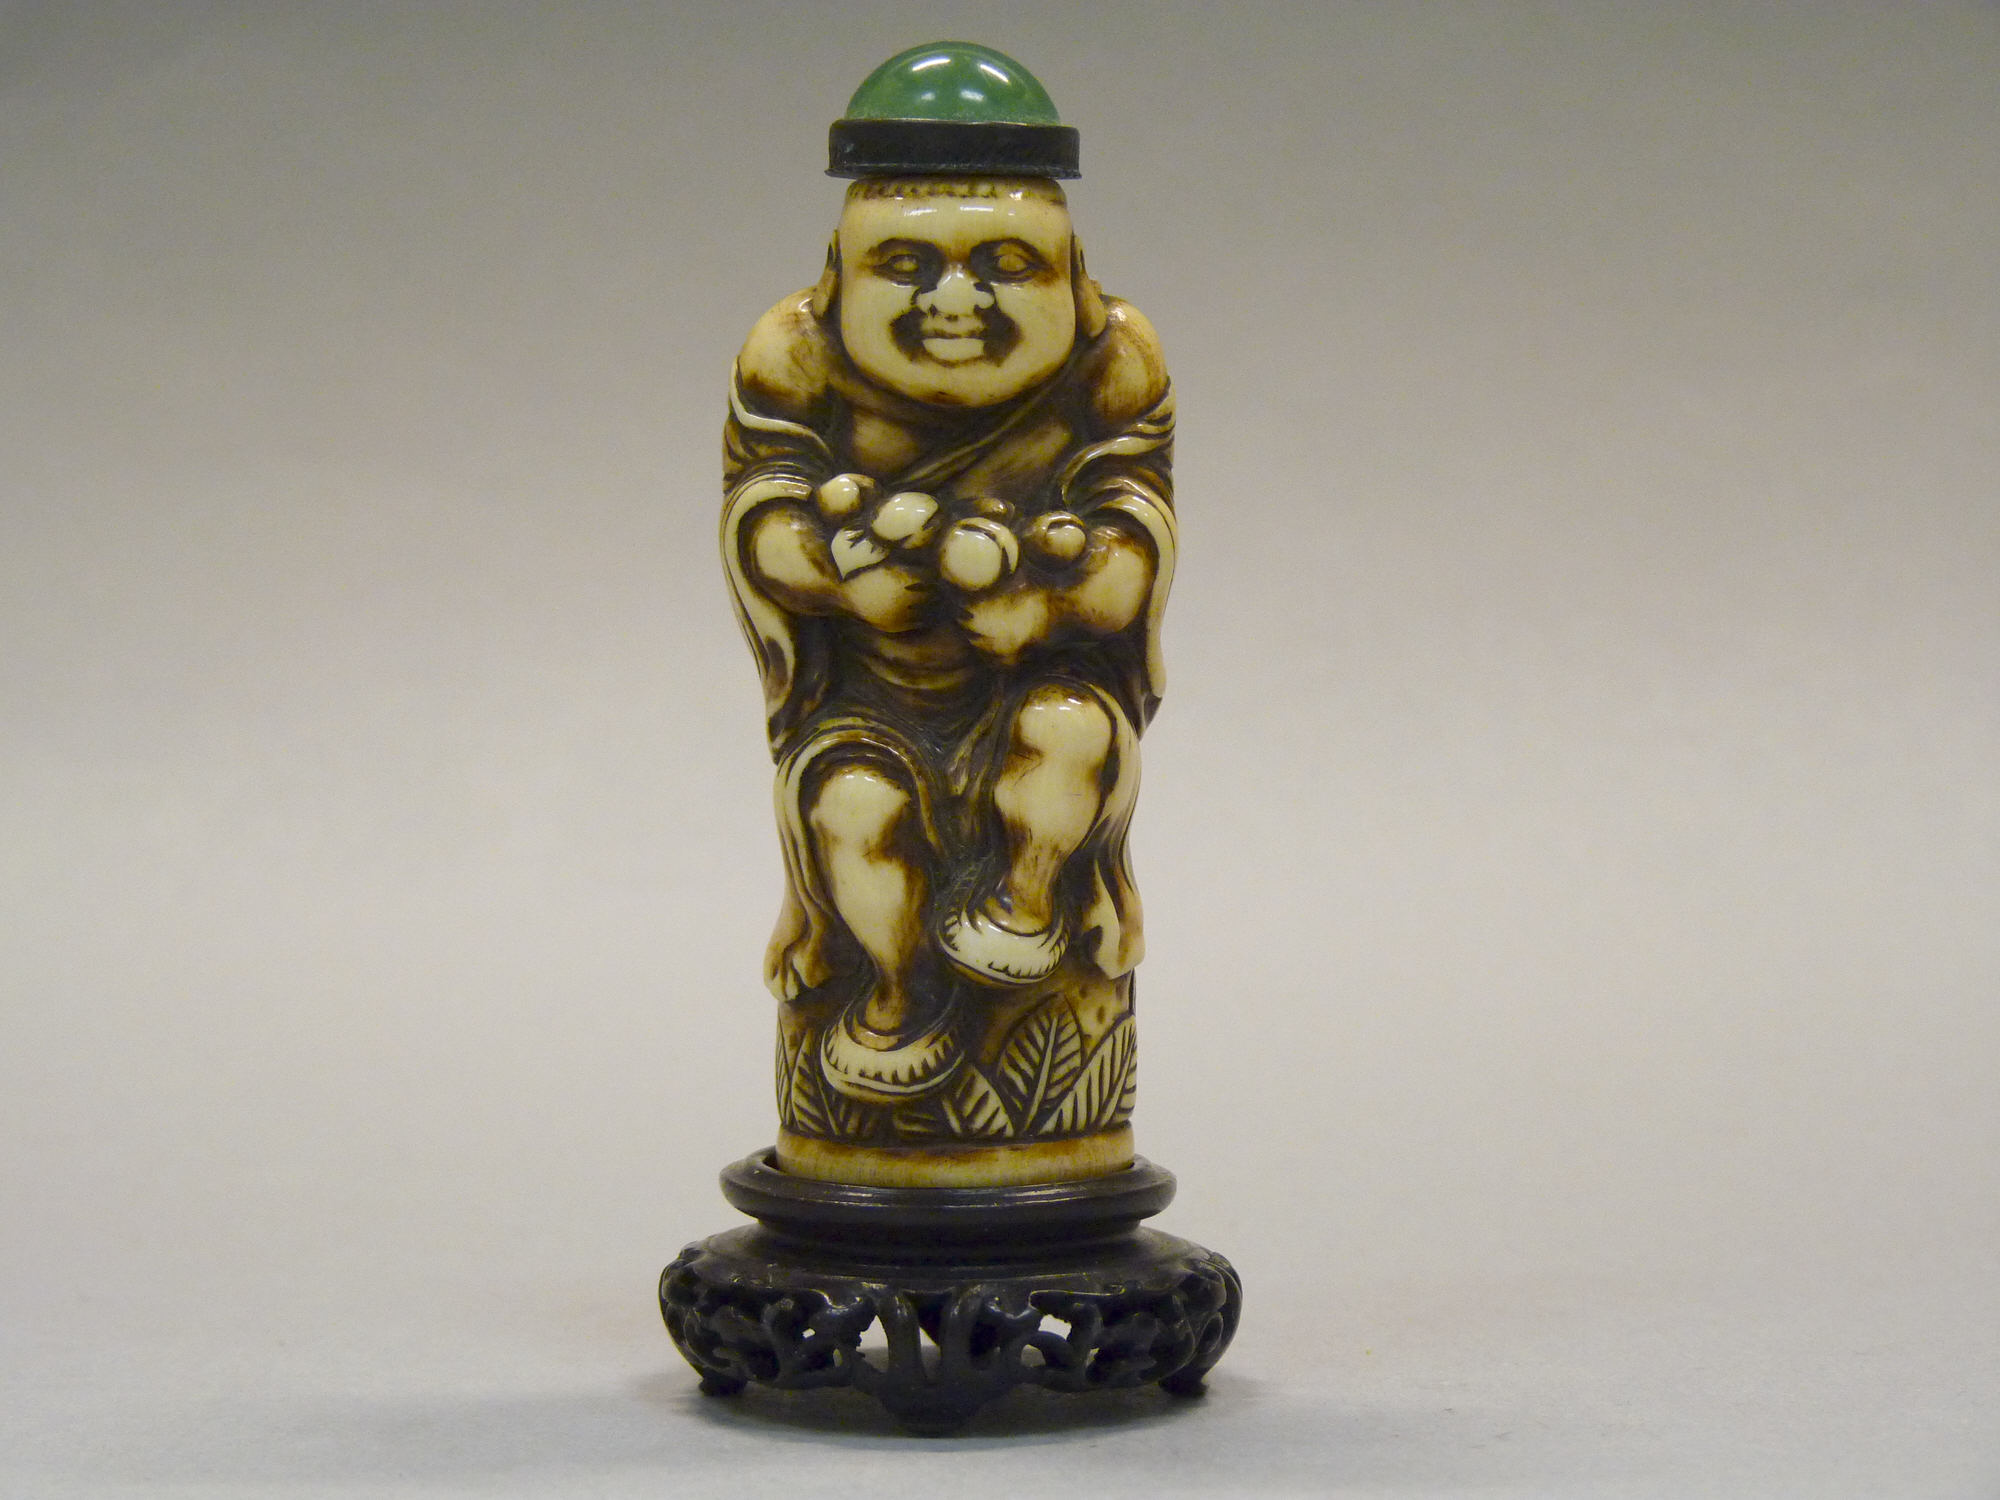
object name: snuff bottle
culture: chinese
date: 1736-1795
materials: glass, ivory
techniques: carving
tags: men